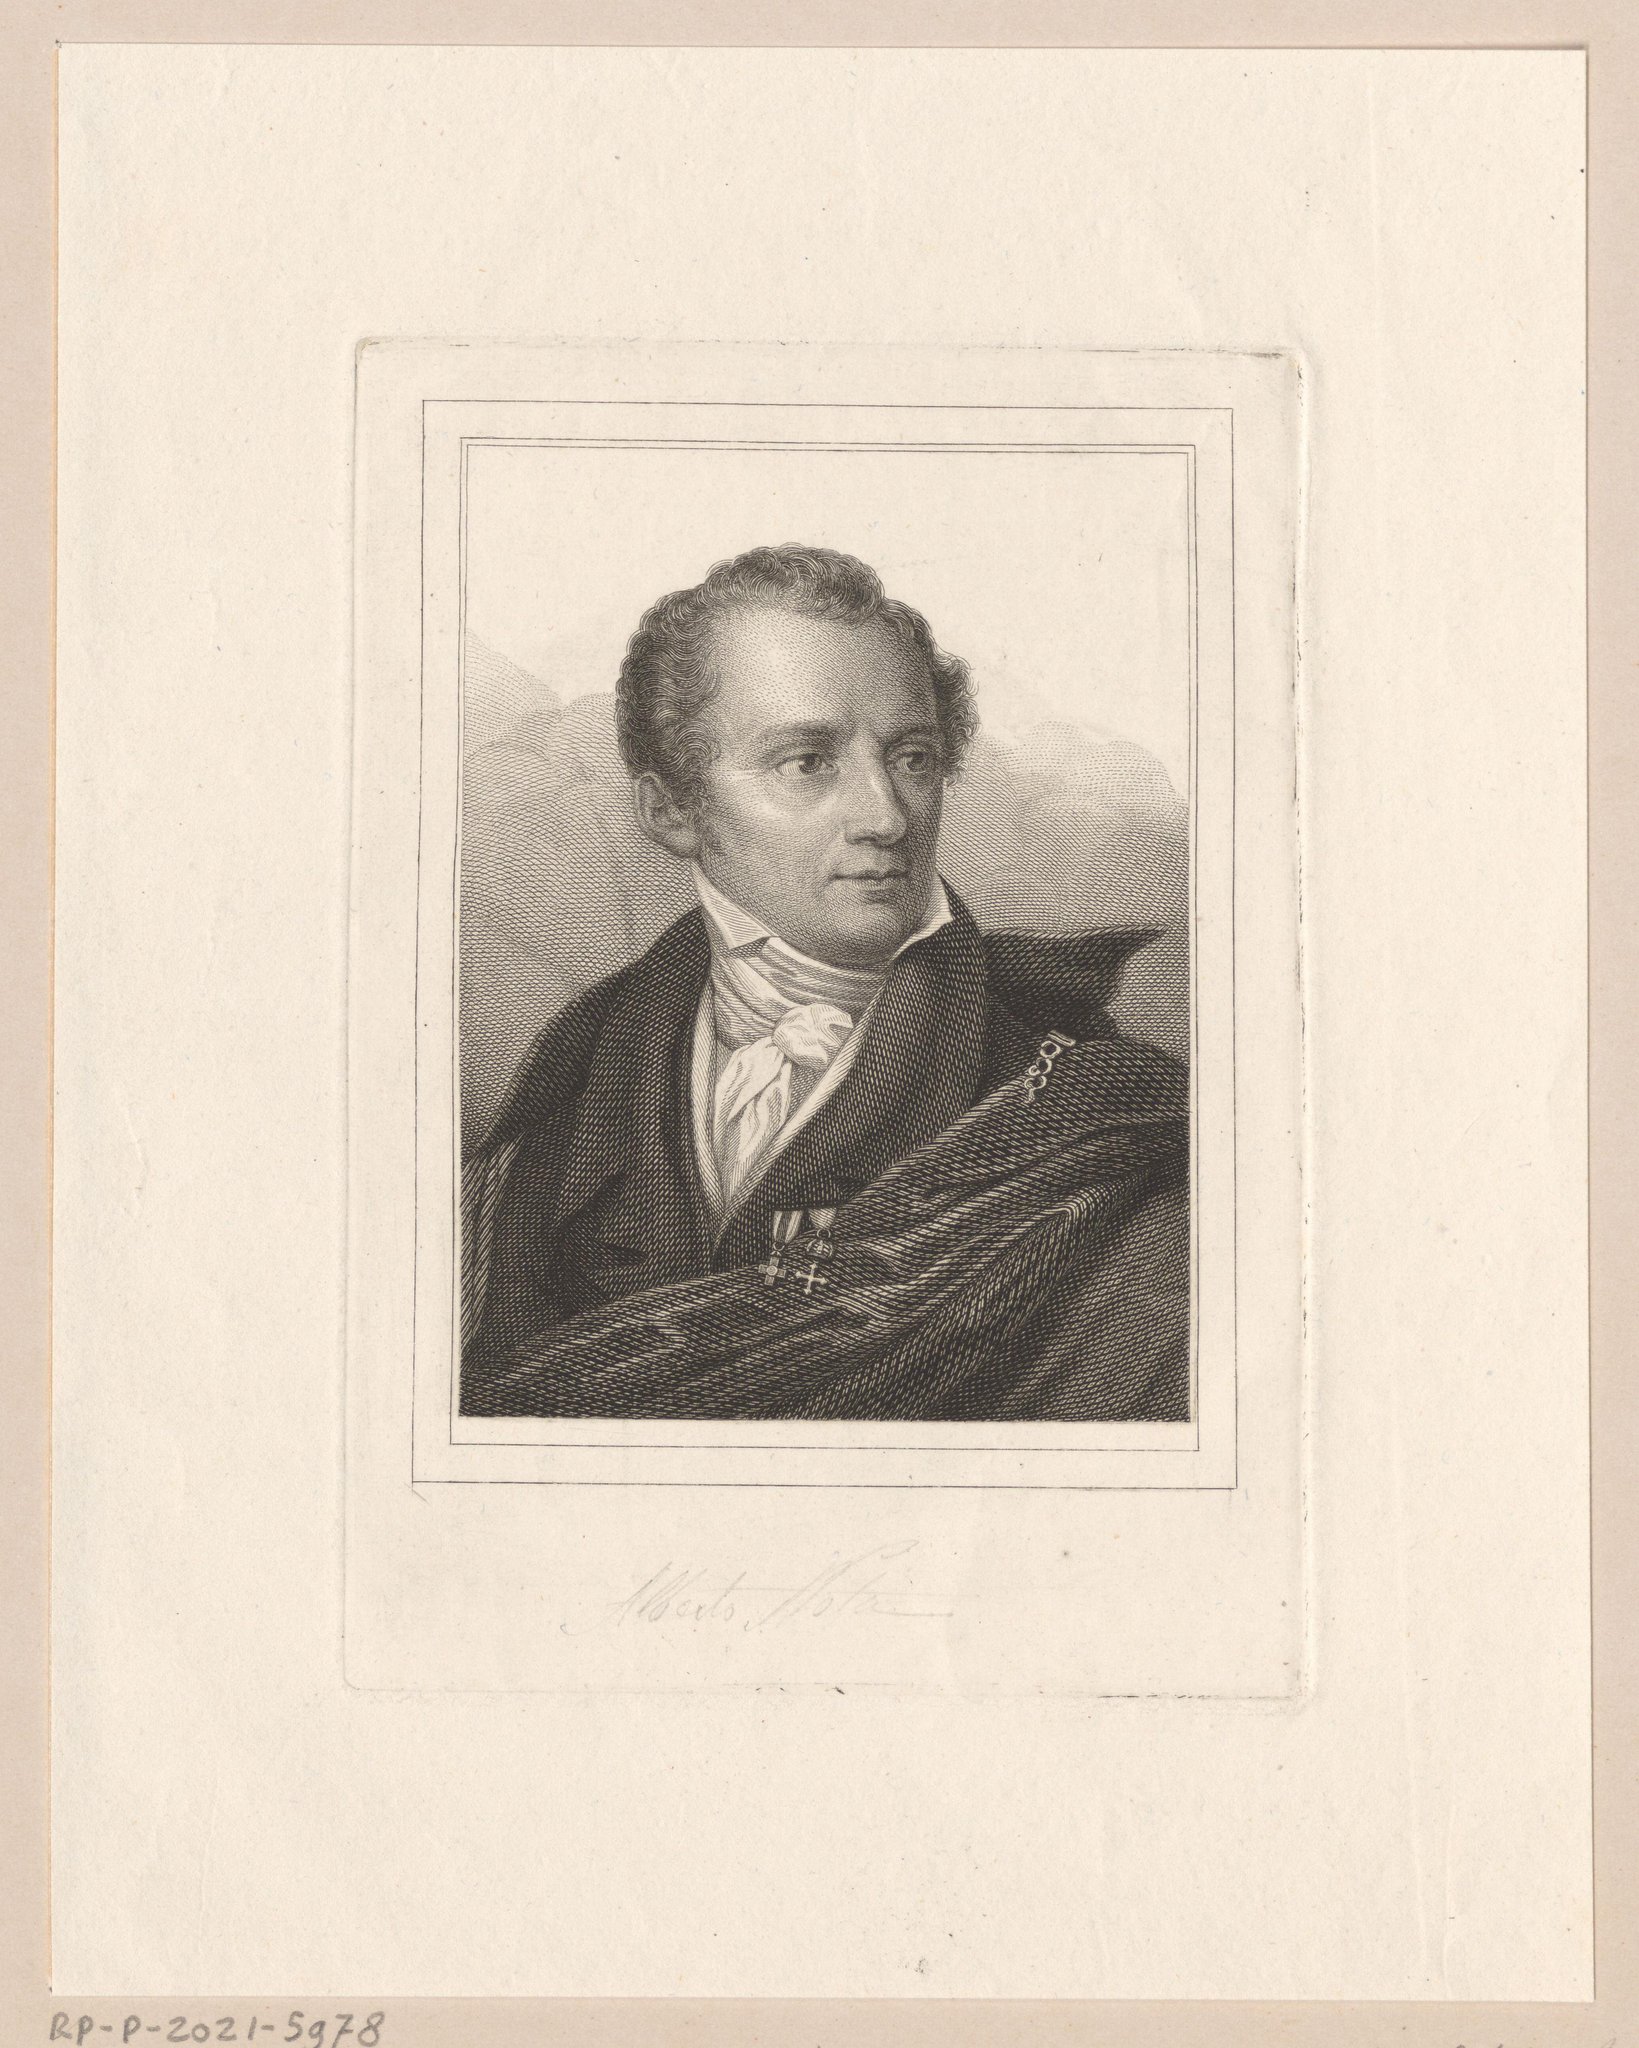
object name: print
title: Portret van Alberto Nota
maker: Anonymous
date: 1800-1849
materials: paper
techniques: engraving, etching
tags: historical persons, writer, poet, author